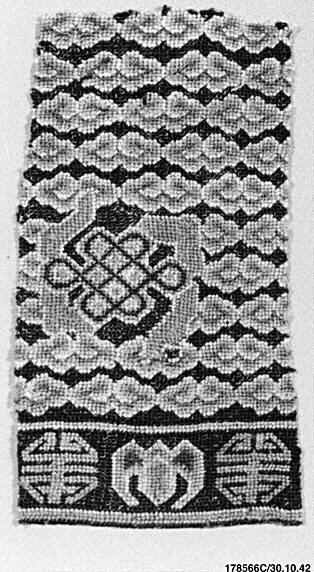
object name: piece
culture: chinese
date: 1801-1900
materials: silk